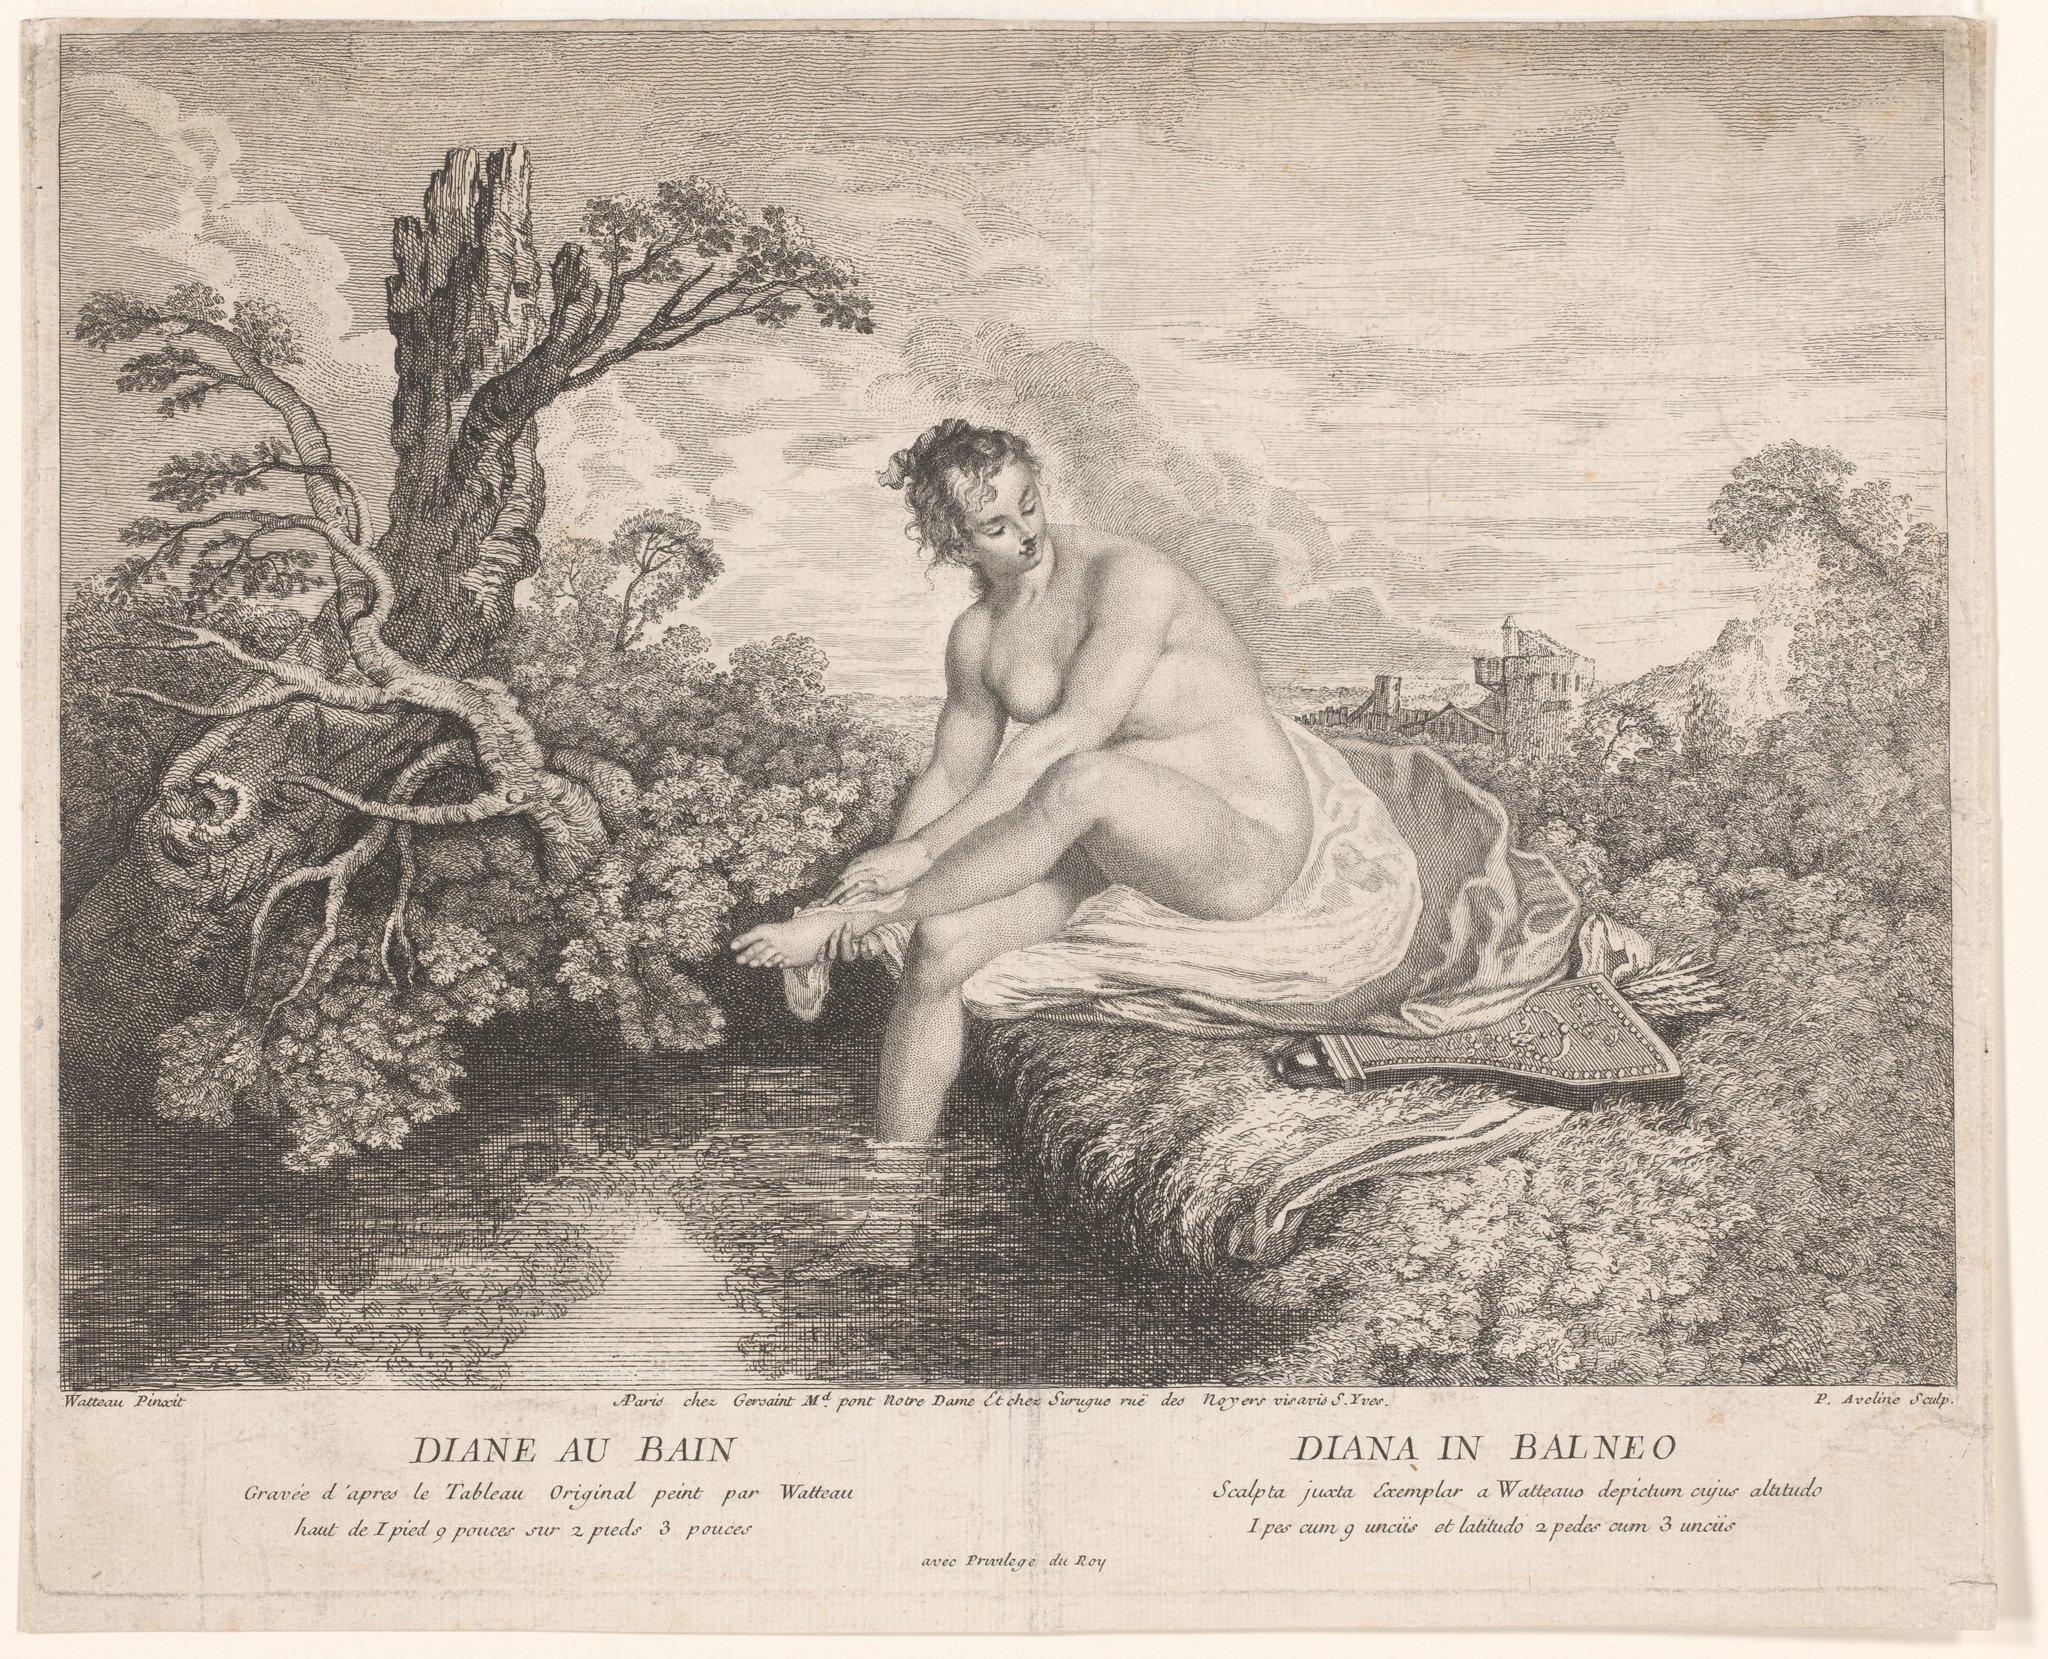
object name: print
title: Diane au bain / Diana in balneo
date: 1712-1750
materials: paper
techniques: etching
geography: paris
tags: pond, pool - hh - ideal landscapes, diana bathing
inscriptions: collector's mark: Lugt 2228